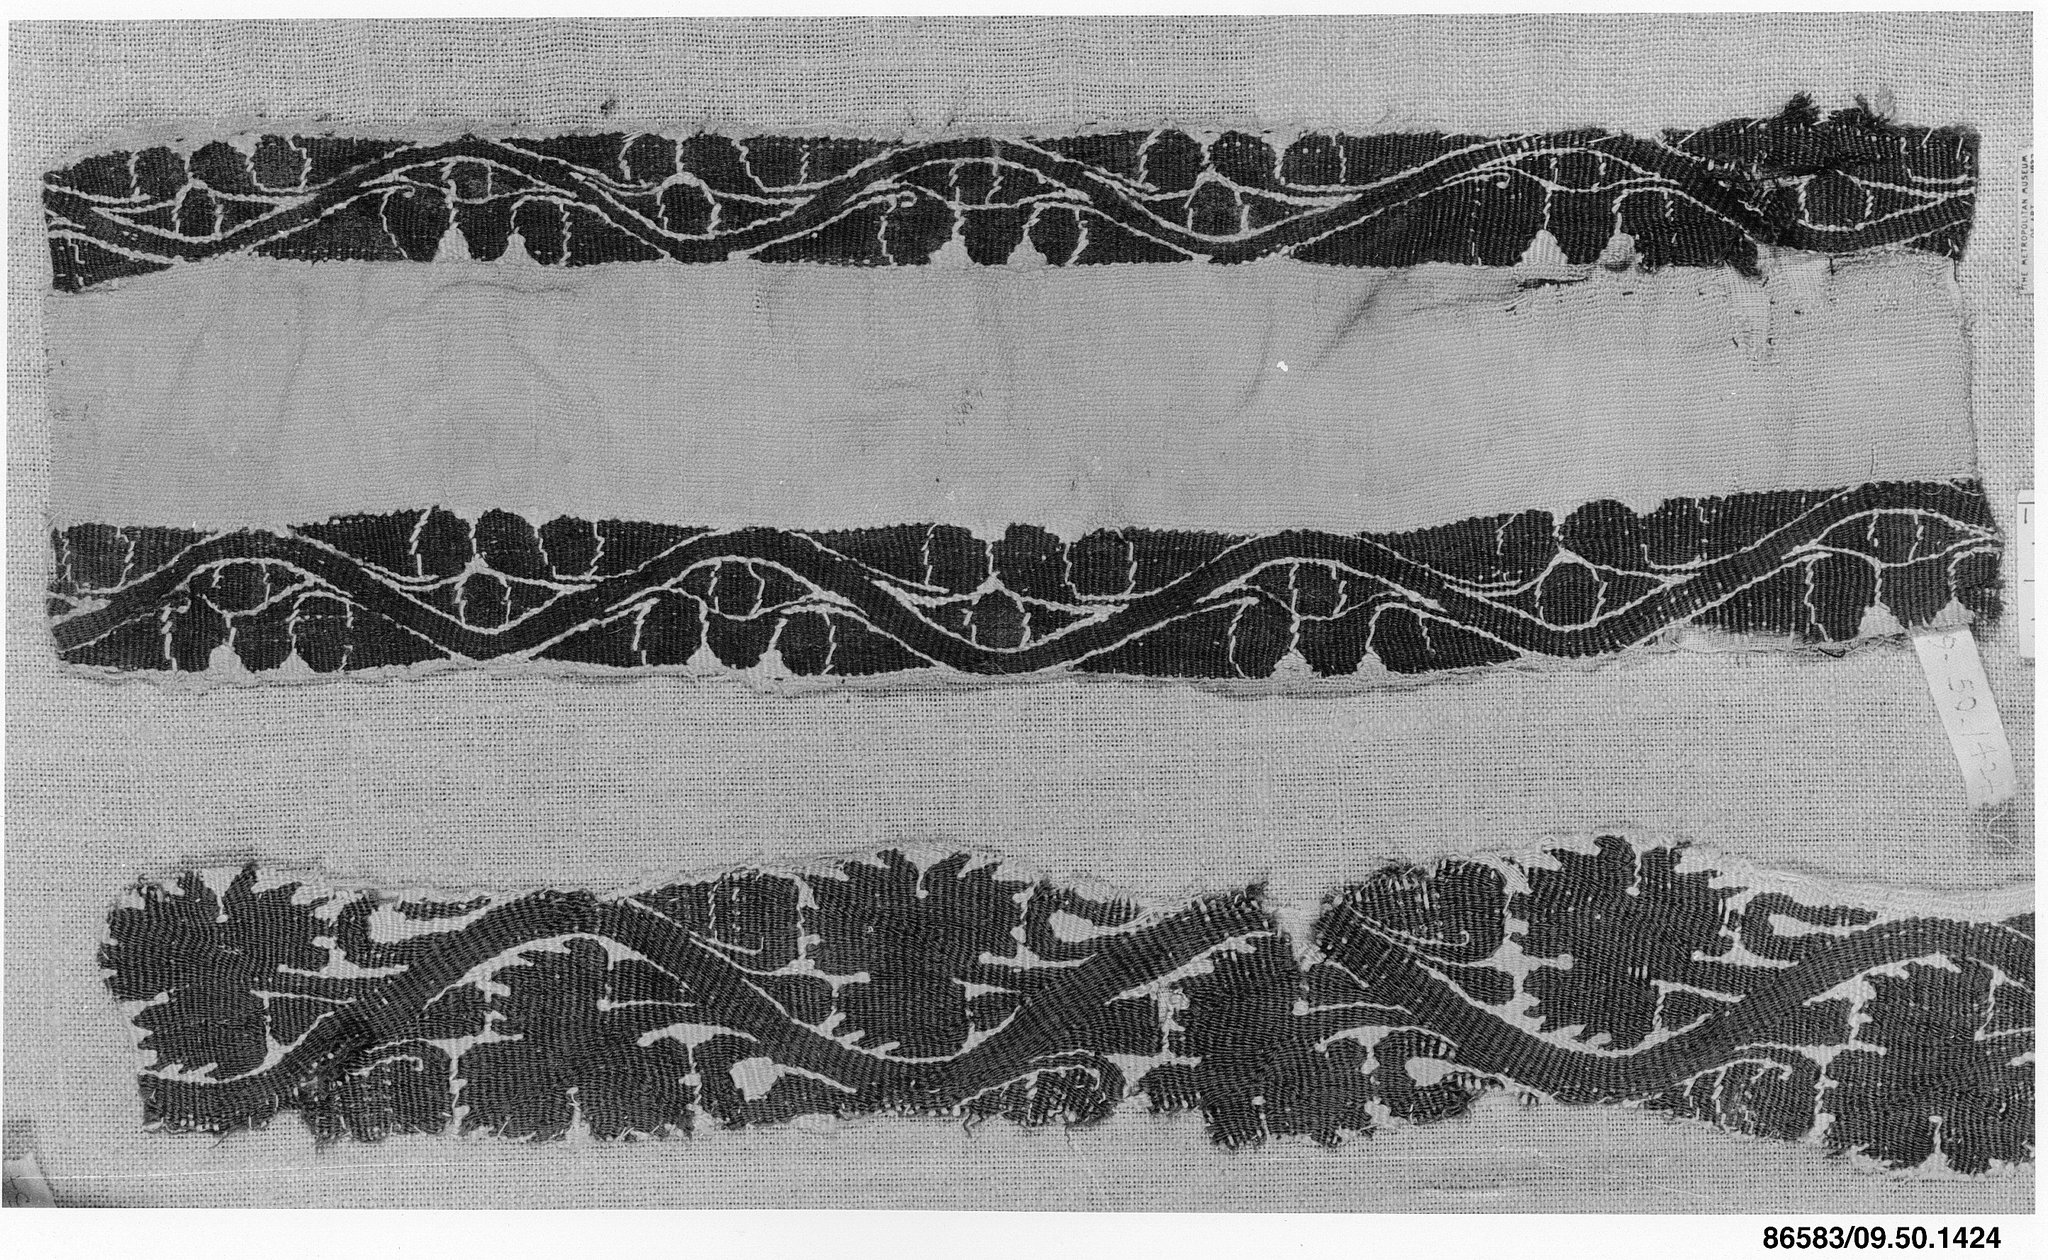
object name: textile fragment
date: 301-500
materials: linen, wool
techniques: weave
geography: egypt